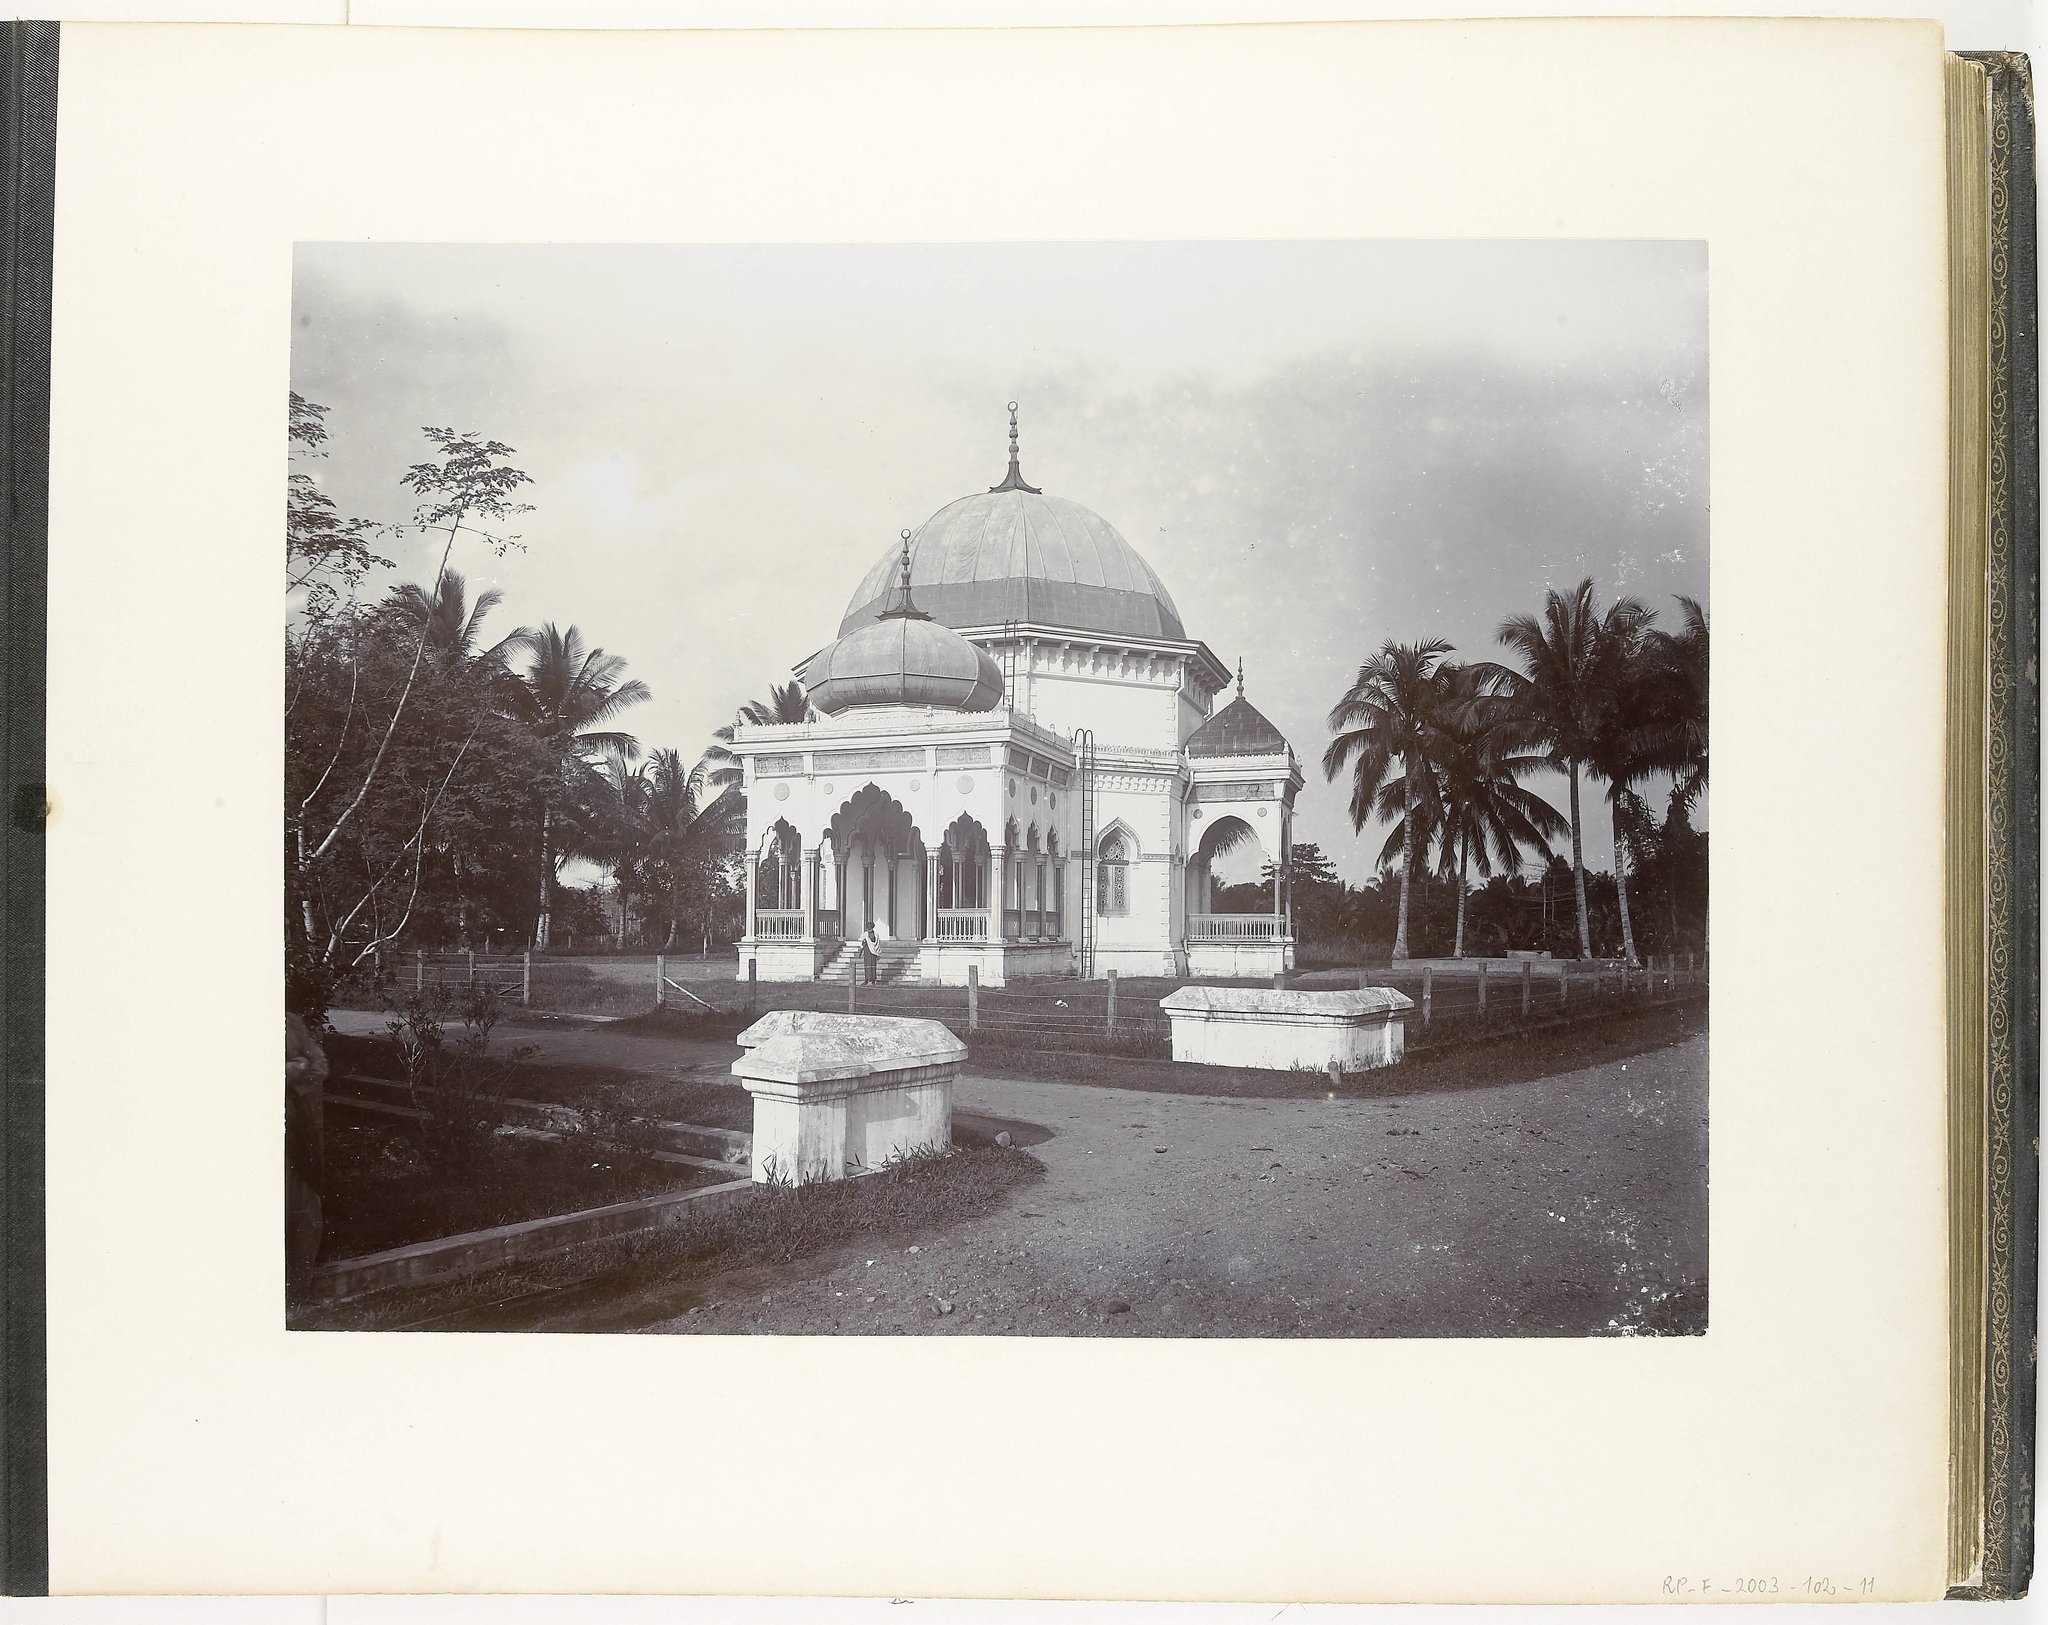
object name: photograph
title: Gezicht op Maleisische Moskee, Sumatra (Malaysischer Moschee )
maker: carl j. kleingrothe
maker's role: fotograaf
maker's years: 1864-1925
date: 1885-1900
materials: photographic support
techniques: collodion silver print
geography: medan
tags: sumatra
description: Gezicht op de Maleisische moskee, waarschijnlijk te Medan. Op de trappen staat een wachter. Onderdeel van het Sumatra fotoalbum van Paul en Lucie Sandel uit 1900.